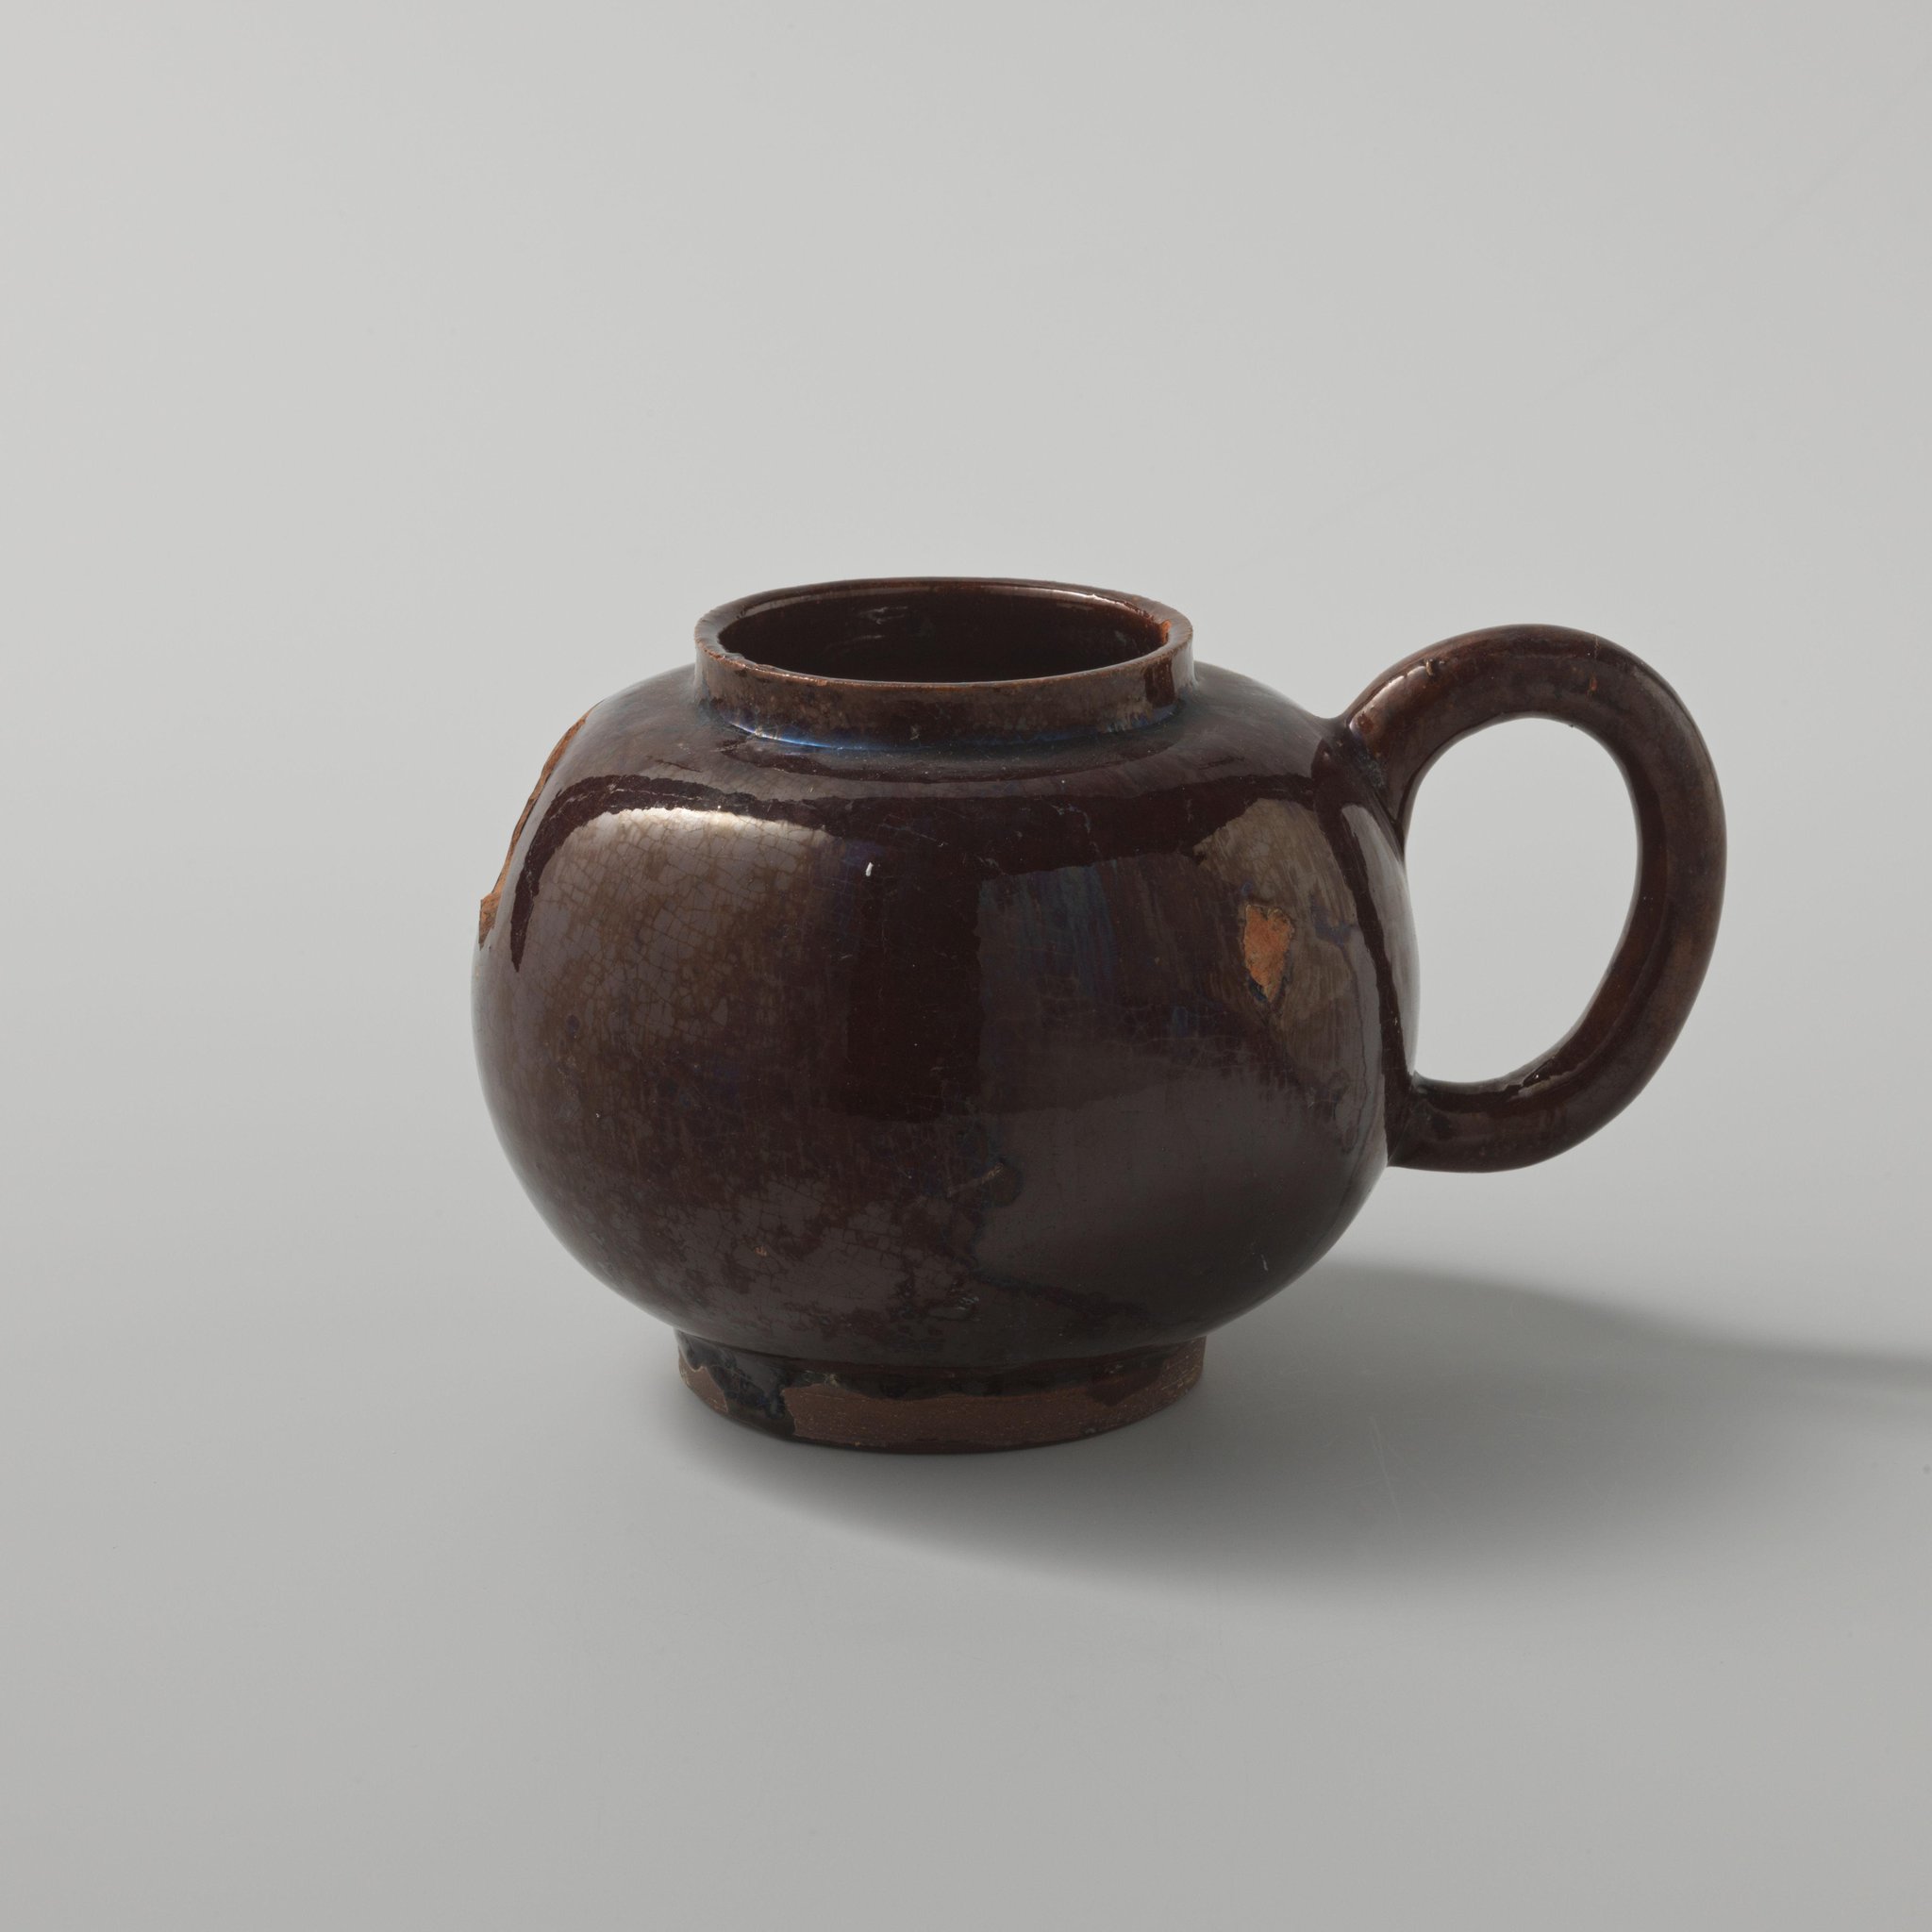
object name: fragment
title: Theepot met een zwart glazuur (De Caluwe bakafval)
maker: jacobus de caluwe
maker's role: plateelbakkerij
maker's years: -1730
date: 1700-1725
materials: earthenware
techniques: firing, vitrification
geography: delft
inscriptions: mark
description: Toegeschreven aan Jacobus de Caluwe, omdat dit voorwerp samen met gemerkte stukken (‘Jacobus De Caluwe’ en rennend hert) gevonden is op de plaats waar zich De Caluwes tweede werkplaats bevond. Er is een duidelijke stilistische overeenkomst tussen de gemerkte en niet gemerkte voorwerpen uit deze archeologische vondst.